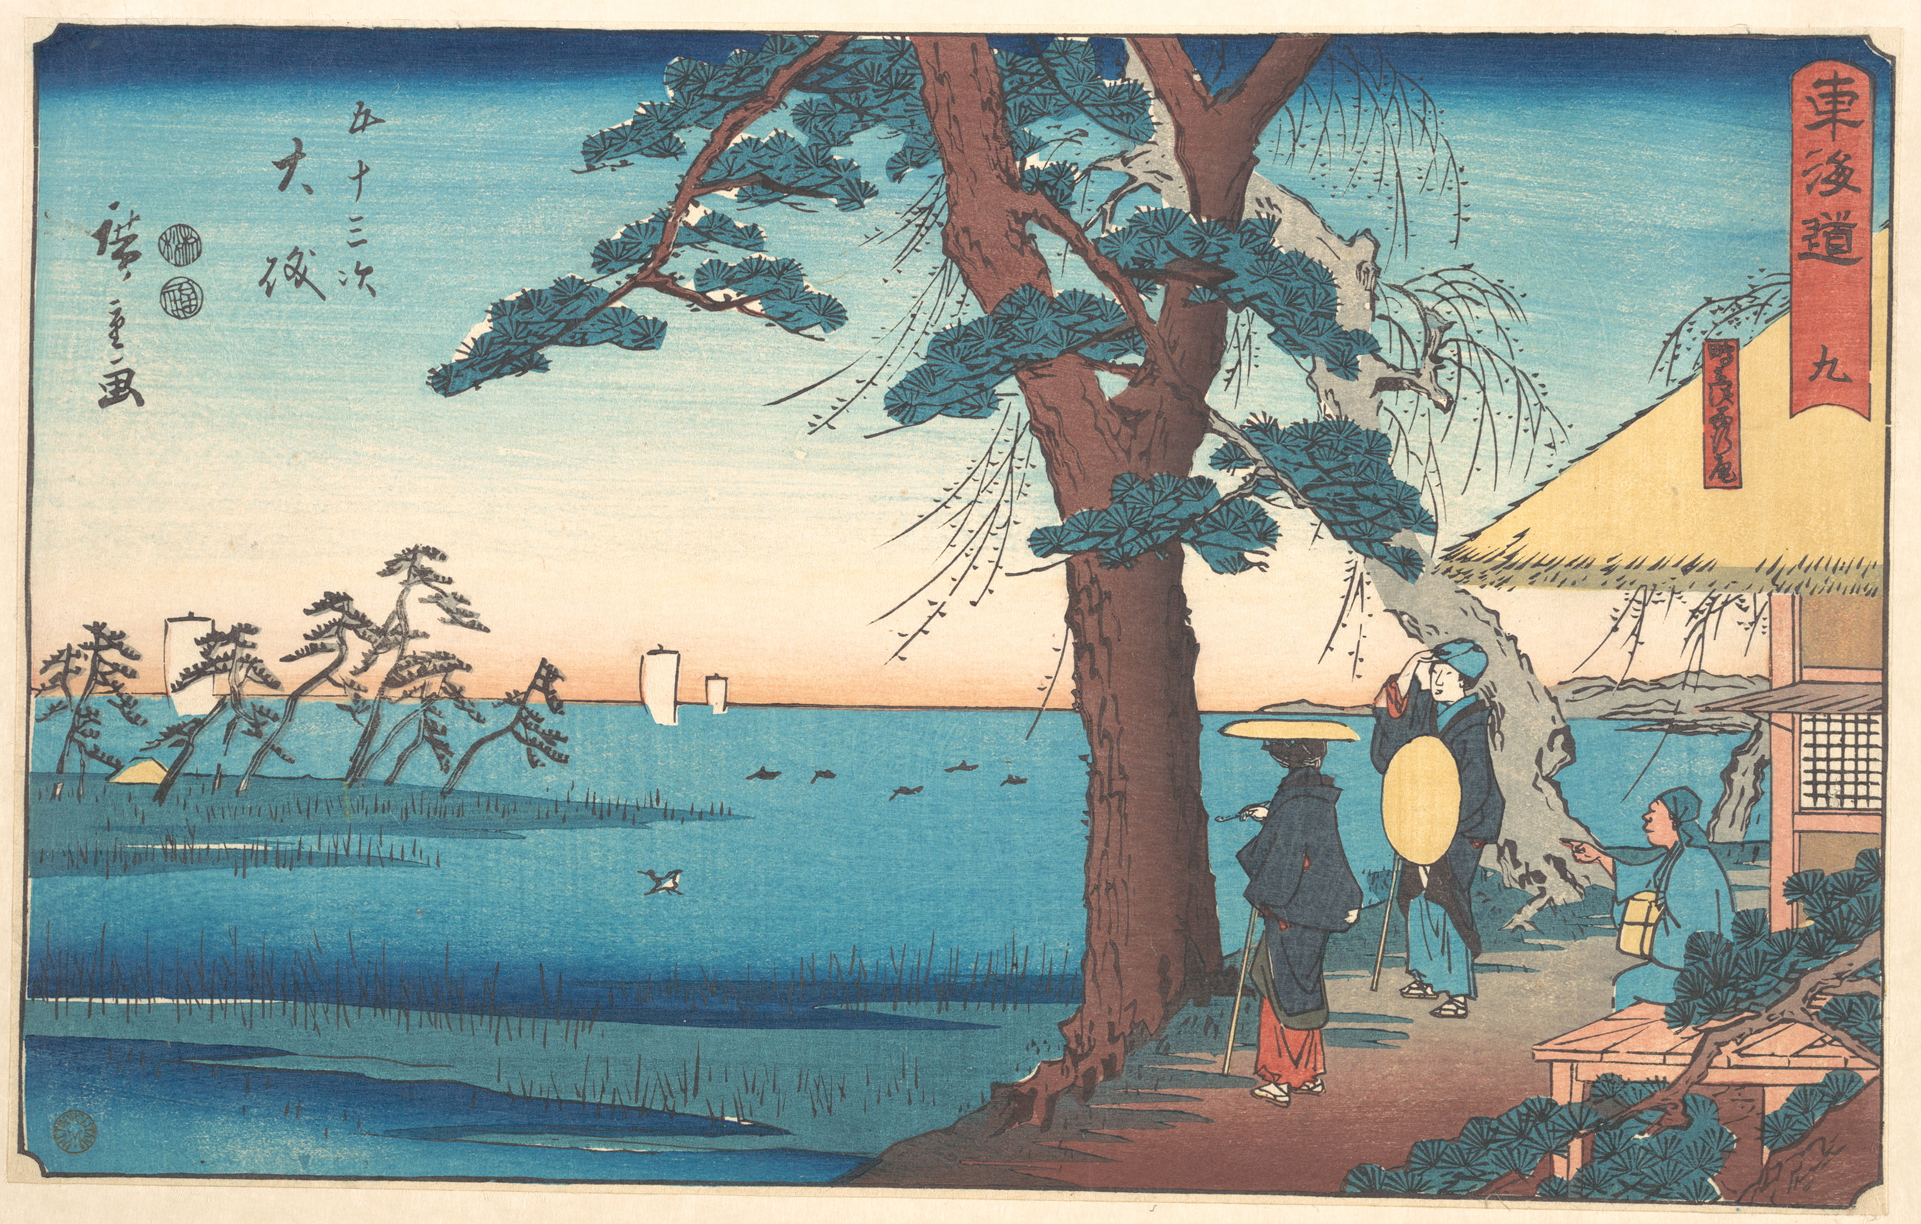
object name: print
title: Ōiso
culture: japanese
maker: utagawa hiroshige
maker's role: artist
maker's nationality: japanese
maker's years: 1797-1858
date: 1840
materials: ink, paper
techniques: woodblock print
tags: men,women,trees